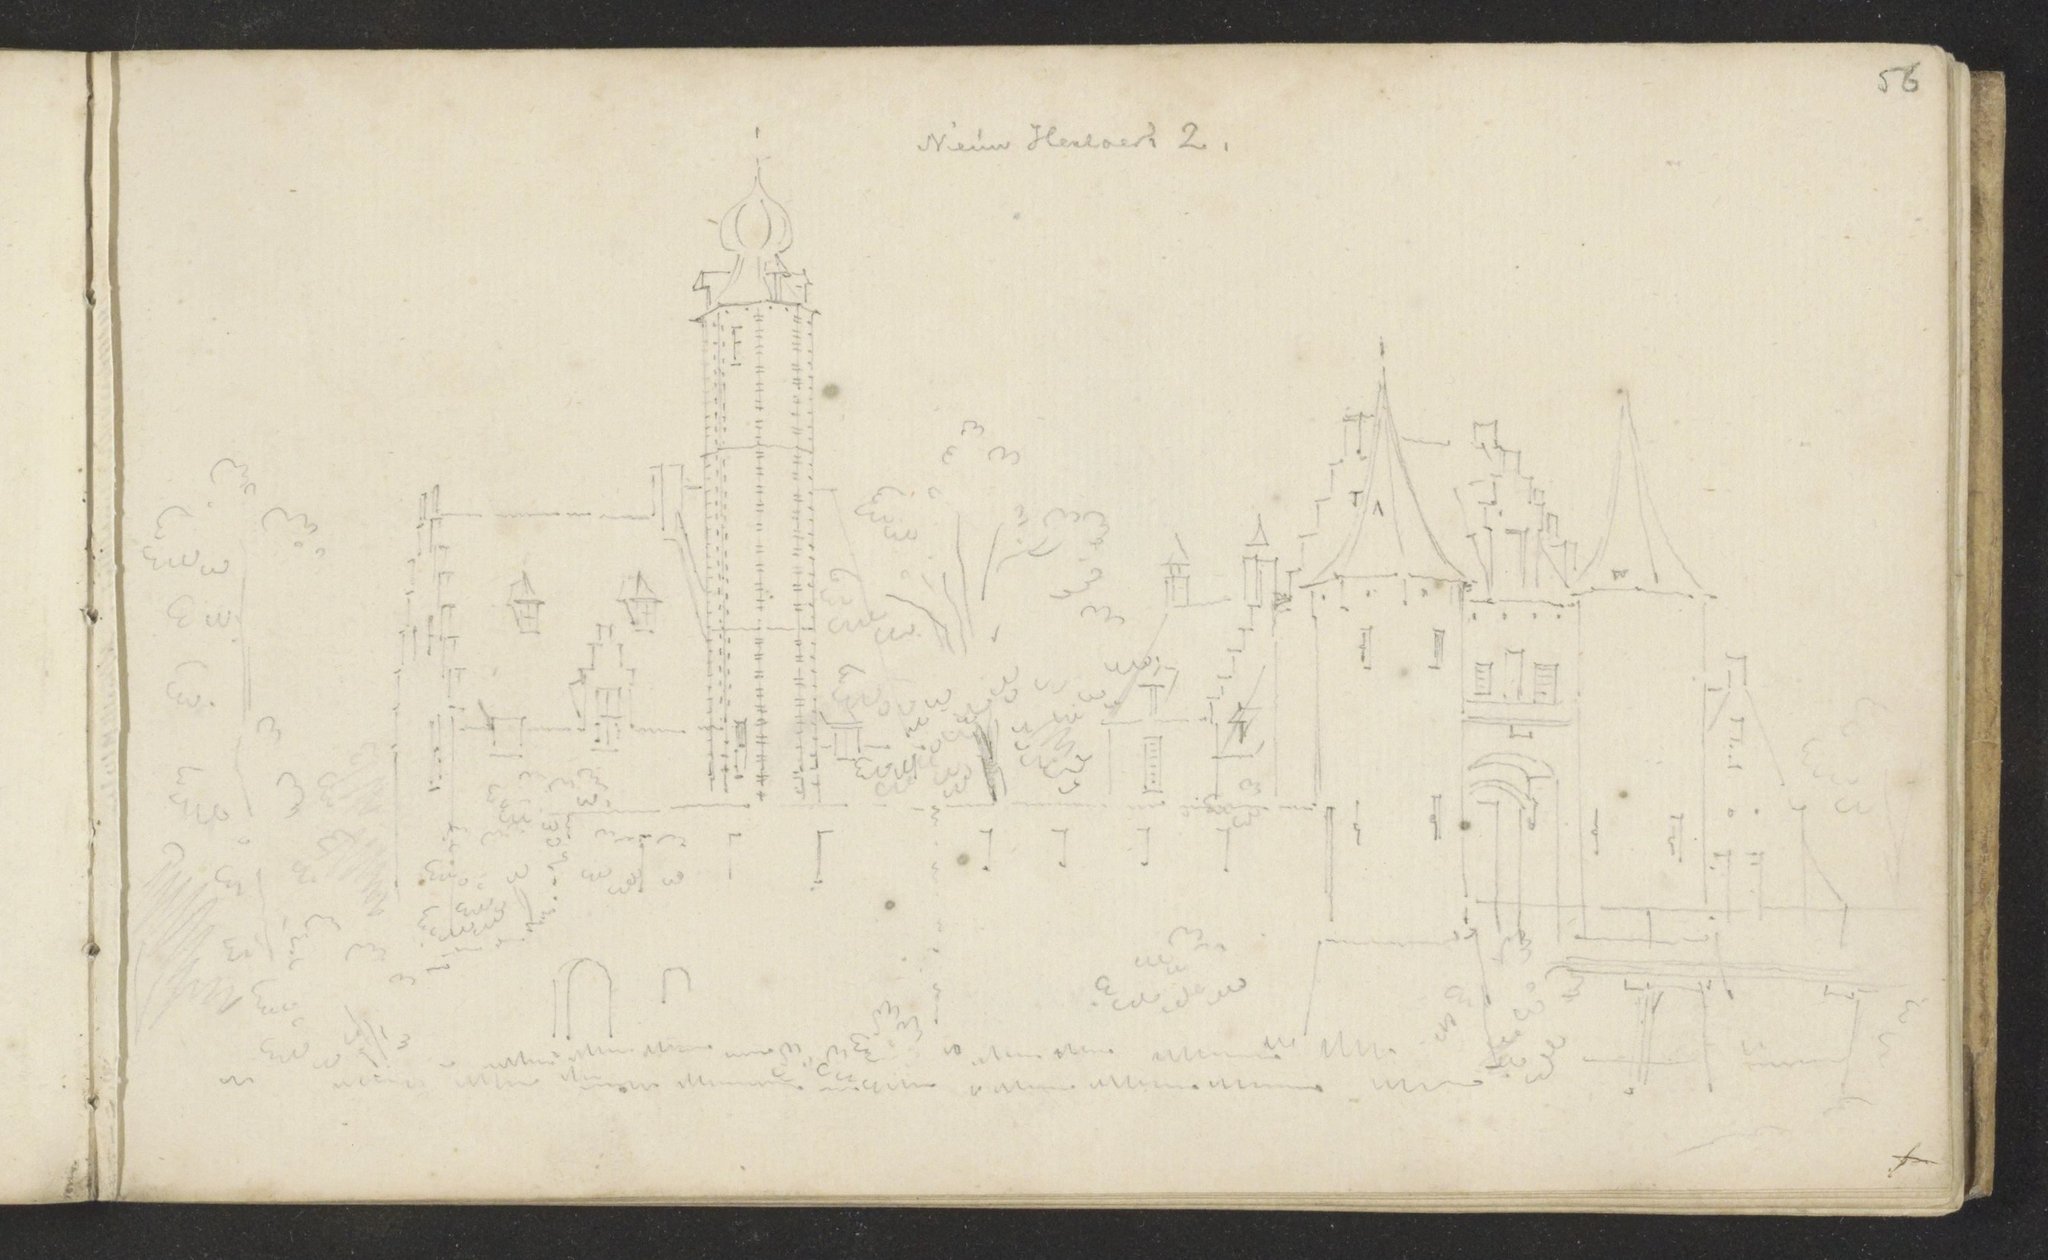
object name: sketchbook leaf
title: Kasteel Nieuw Herlaer te Sint-Michielsgestel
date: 1701-1759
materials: paper, pencil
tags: castle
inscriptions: annotation: ‘Nieuw Herlaer Z.’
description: Blad 56 recto uit een schetsboek met 65 bladen.